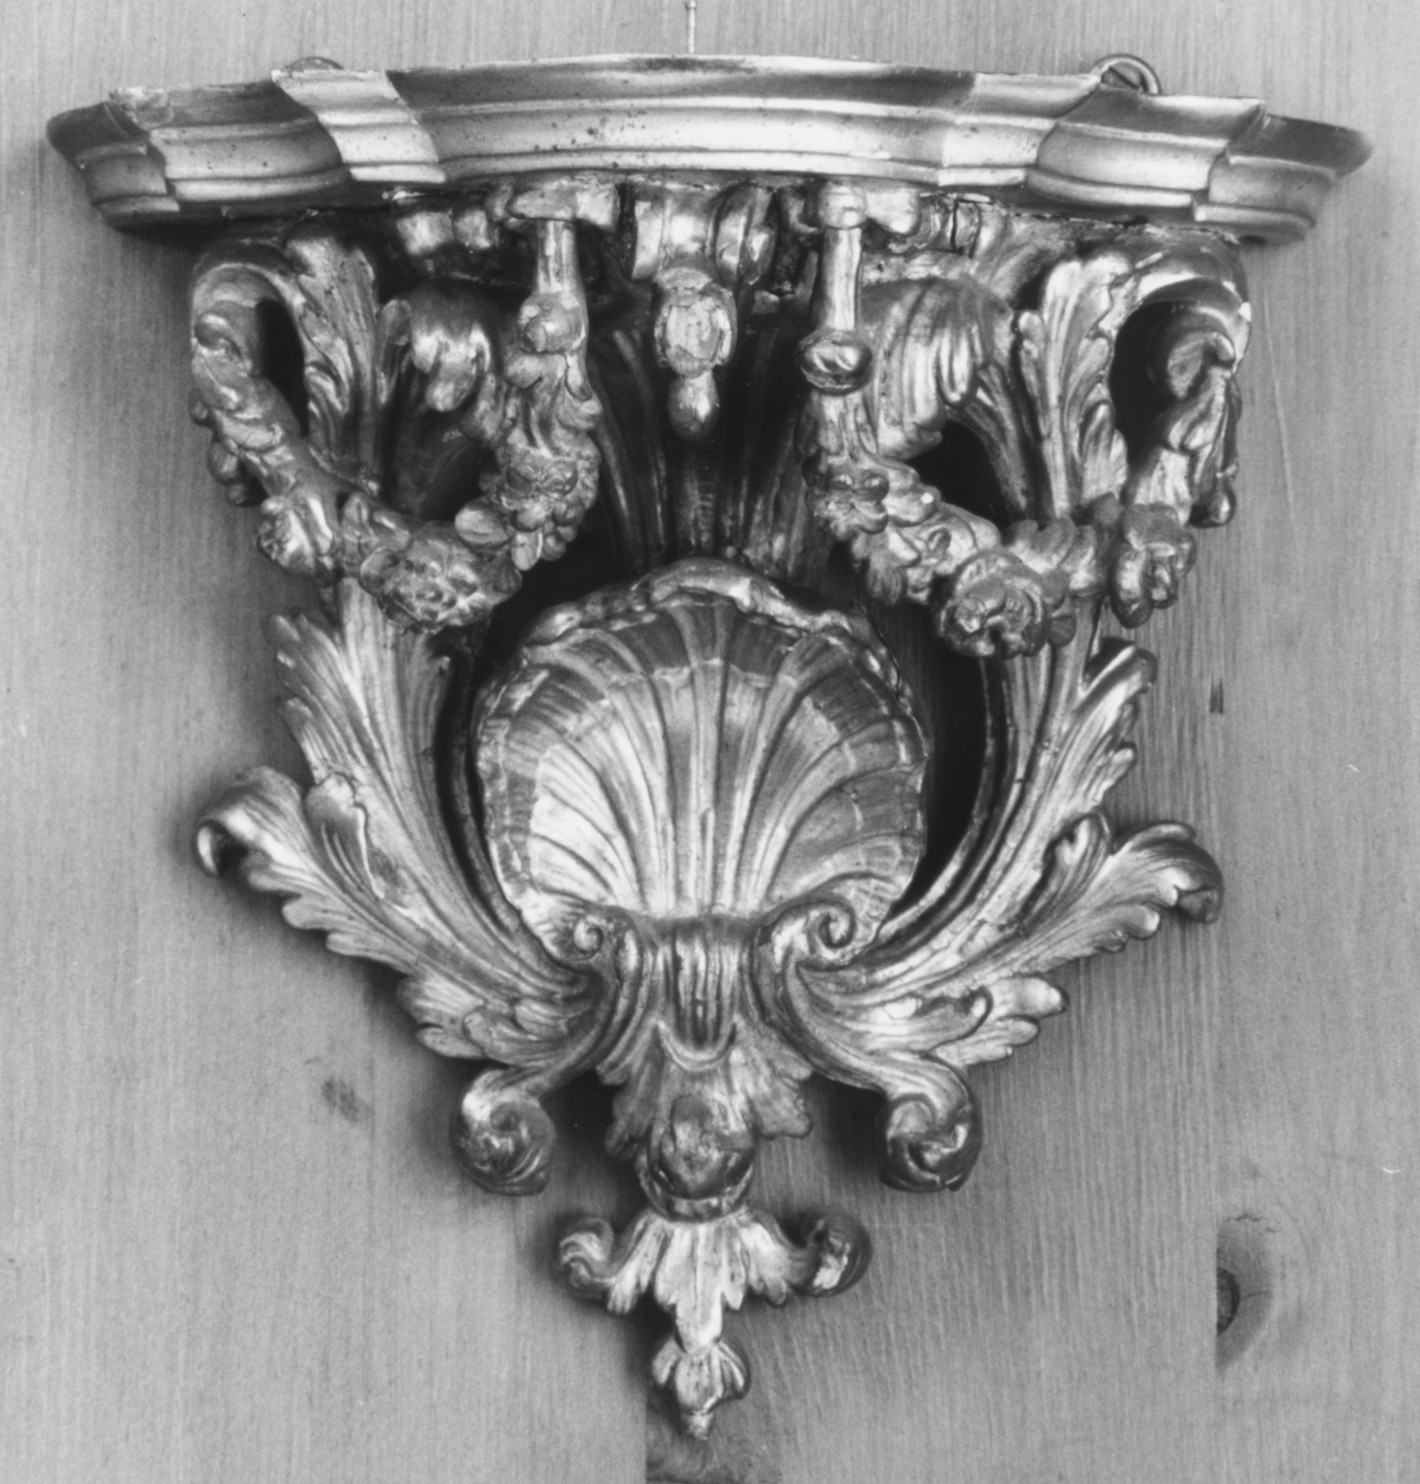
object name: wall bracket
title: Pair of wall brackets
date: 1725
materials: wood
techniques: carving, gilding